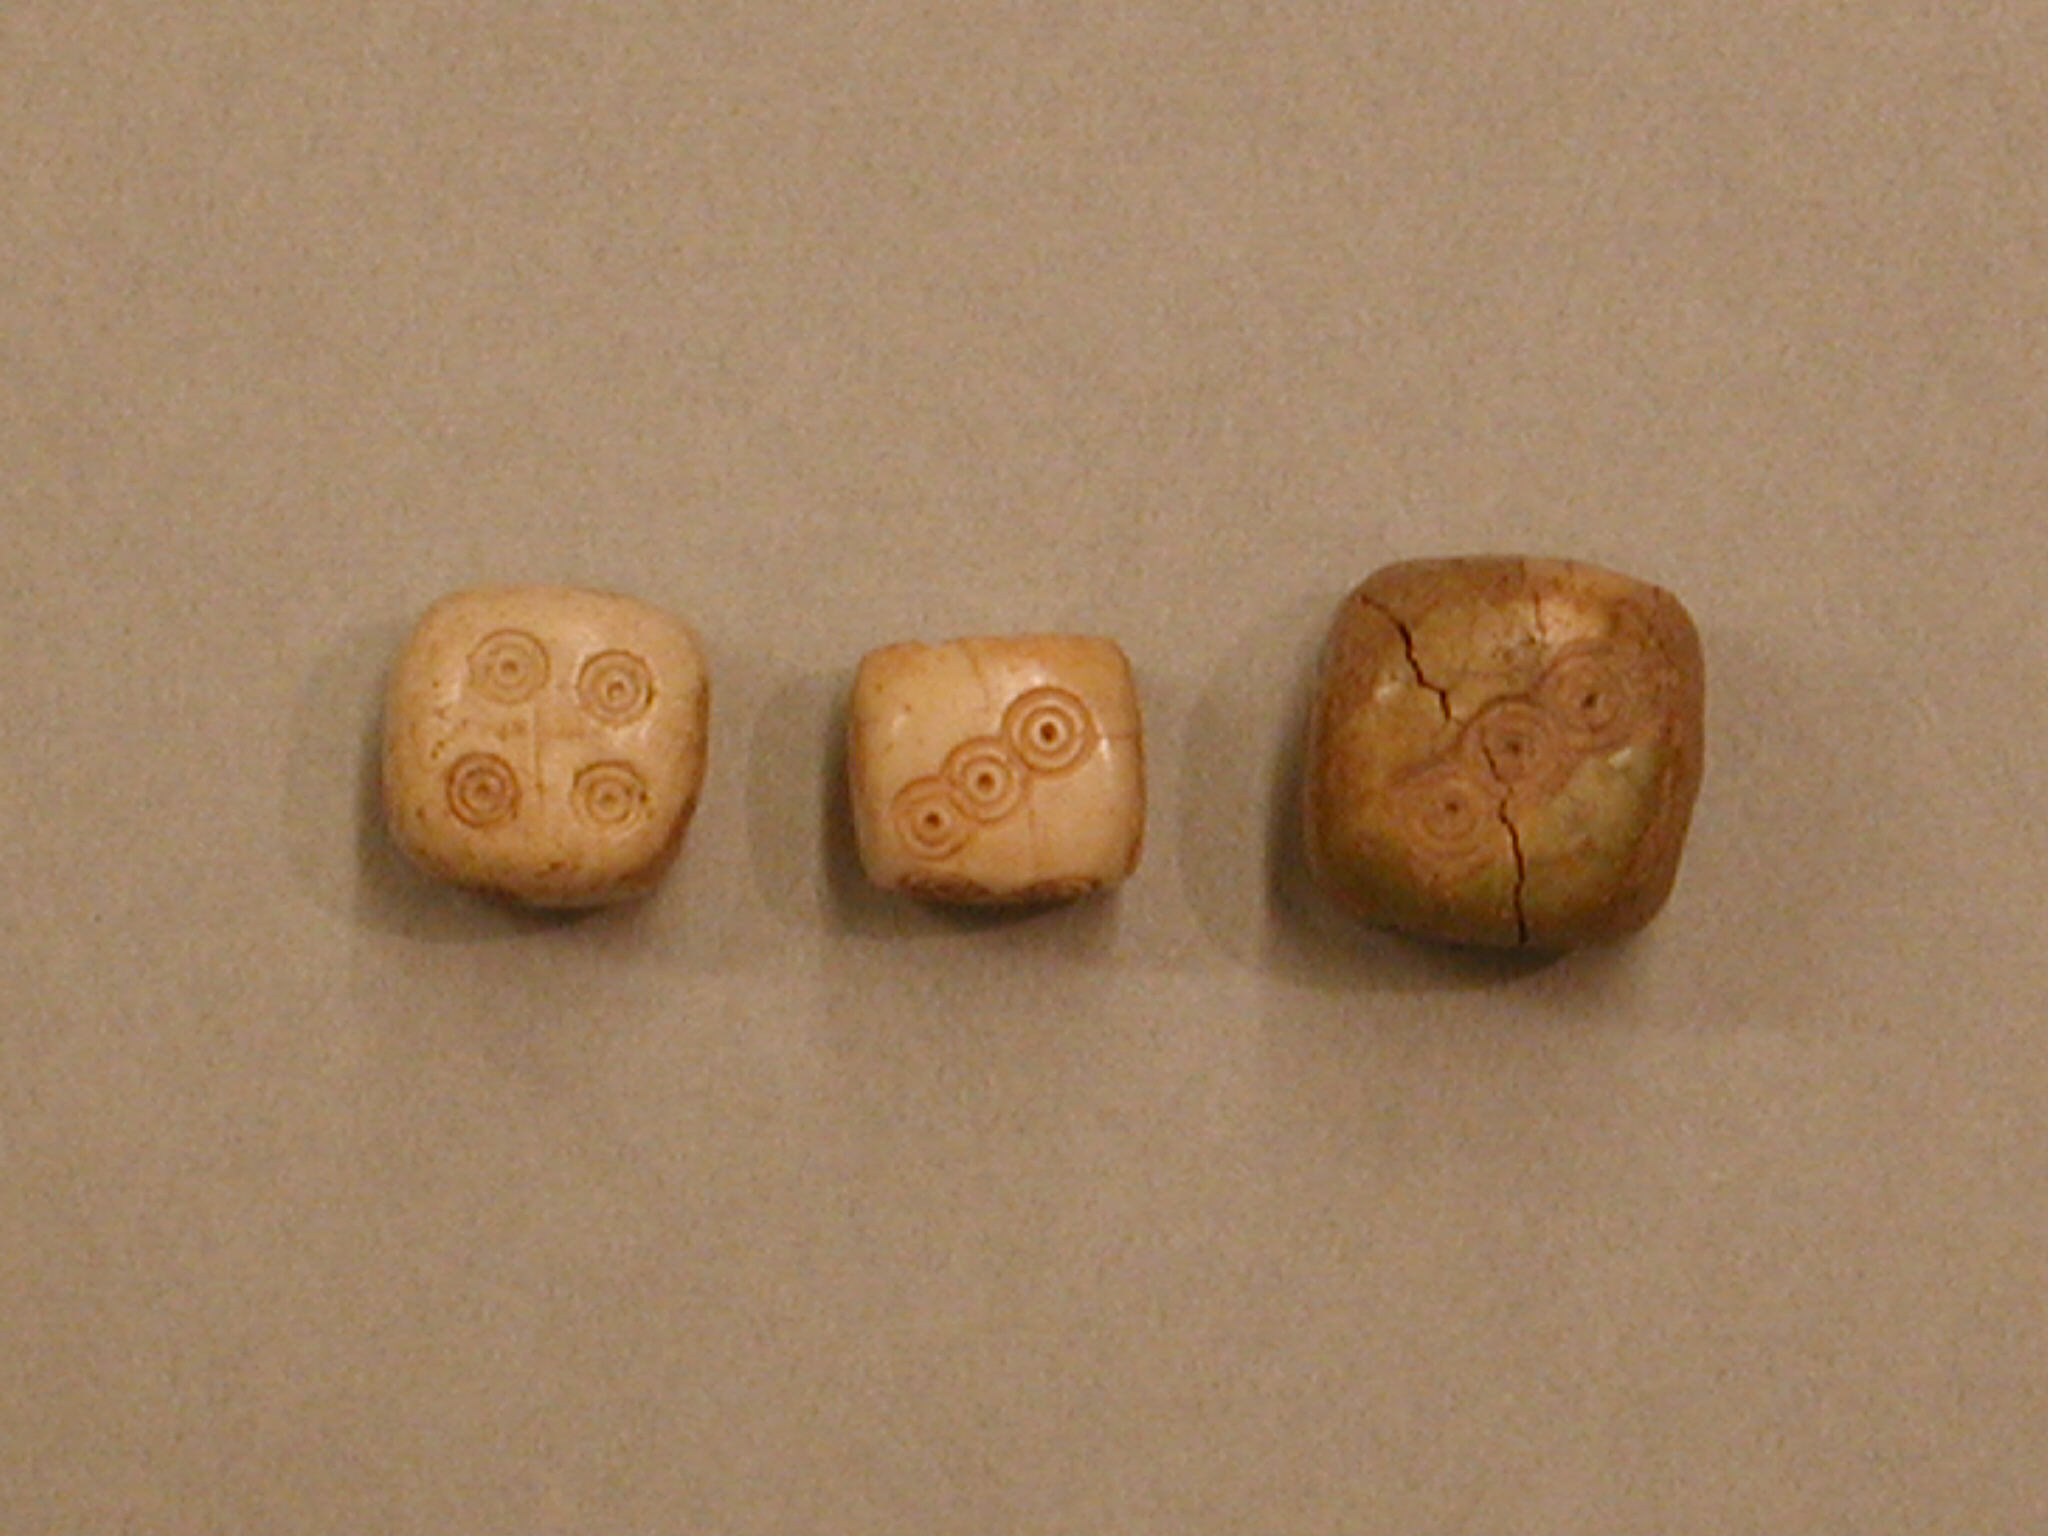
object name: dice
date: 801-1000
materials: bone, paint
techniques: incising, inlay, tinting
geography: iran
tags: dice